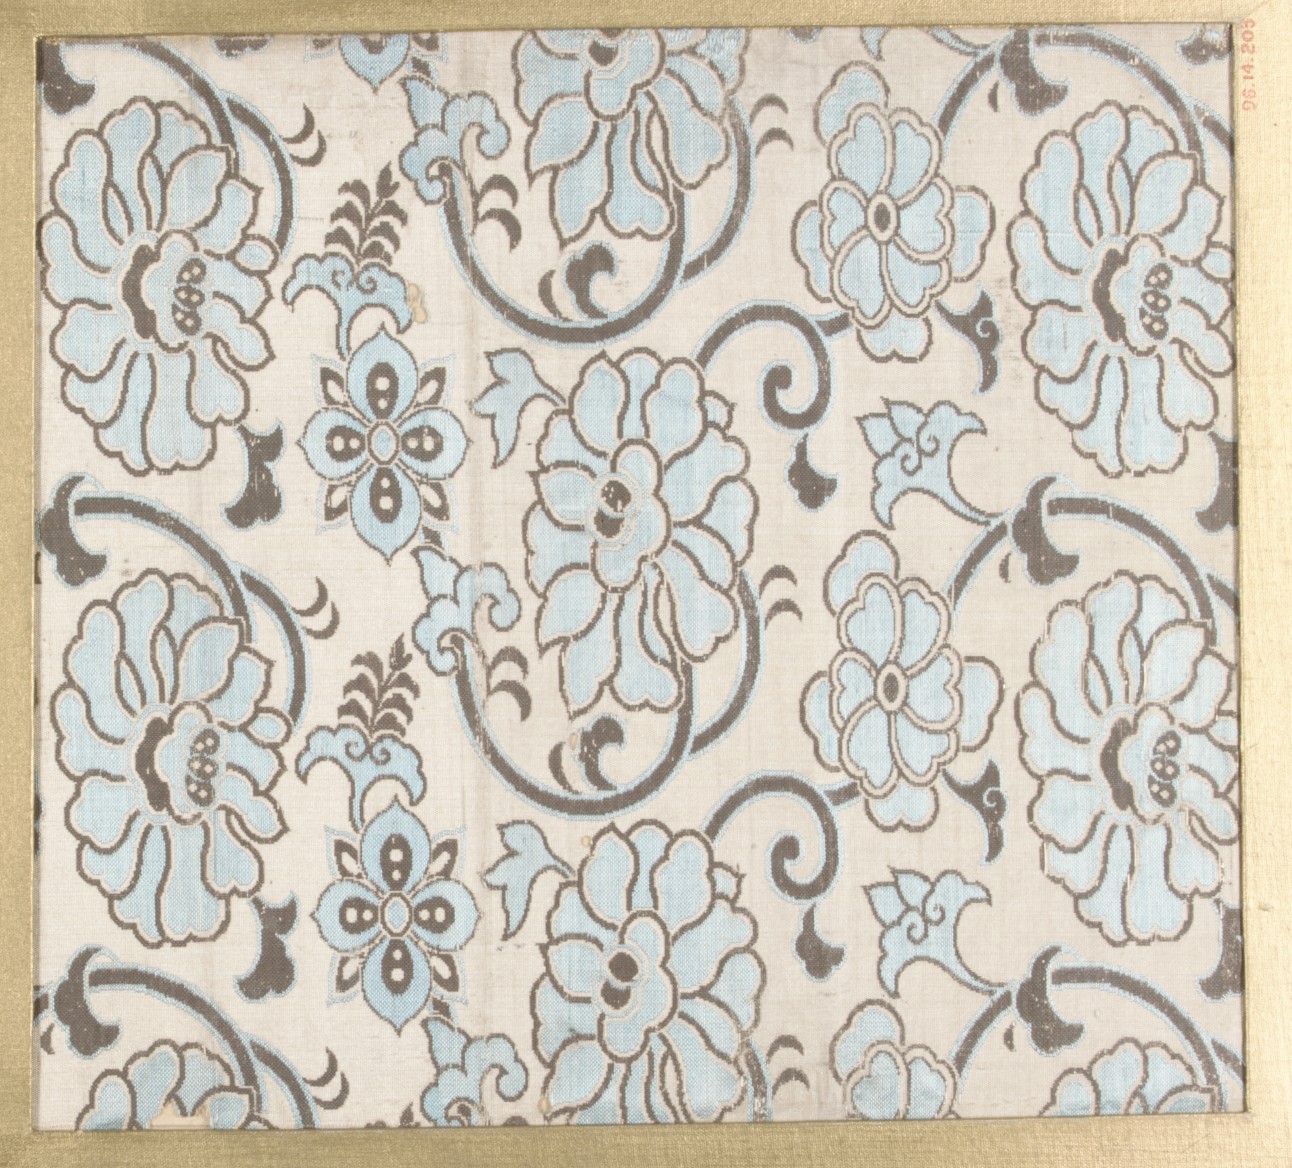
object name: piece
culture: japanese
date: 1701-1900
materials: silk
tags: flowers